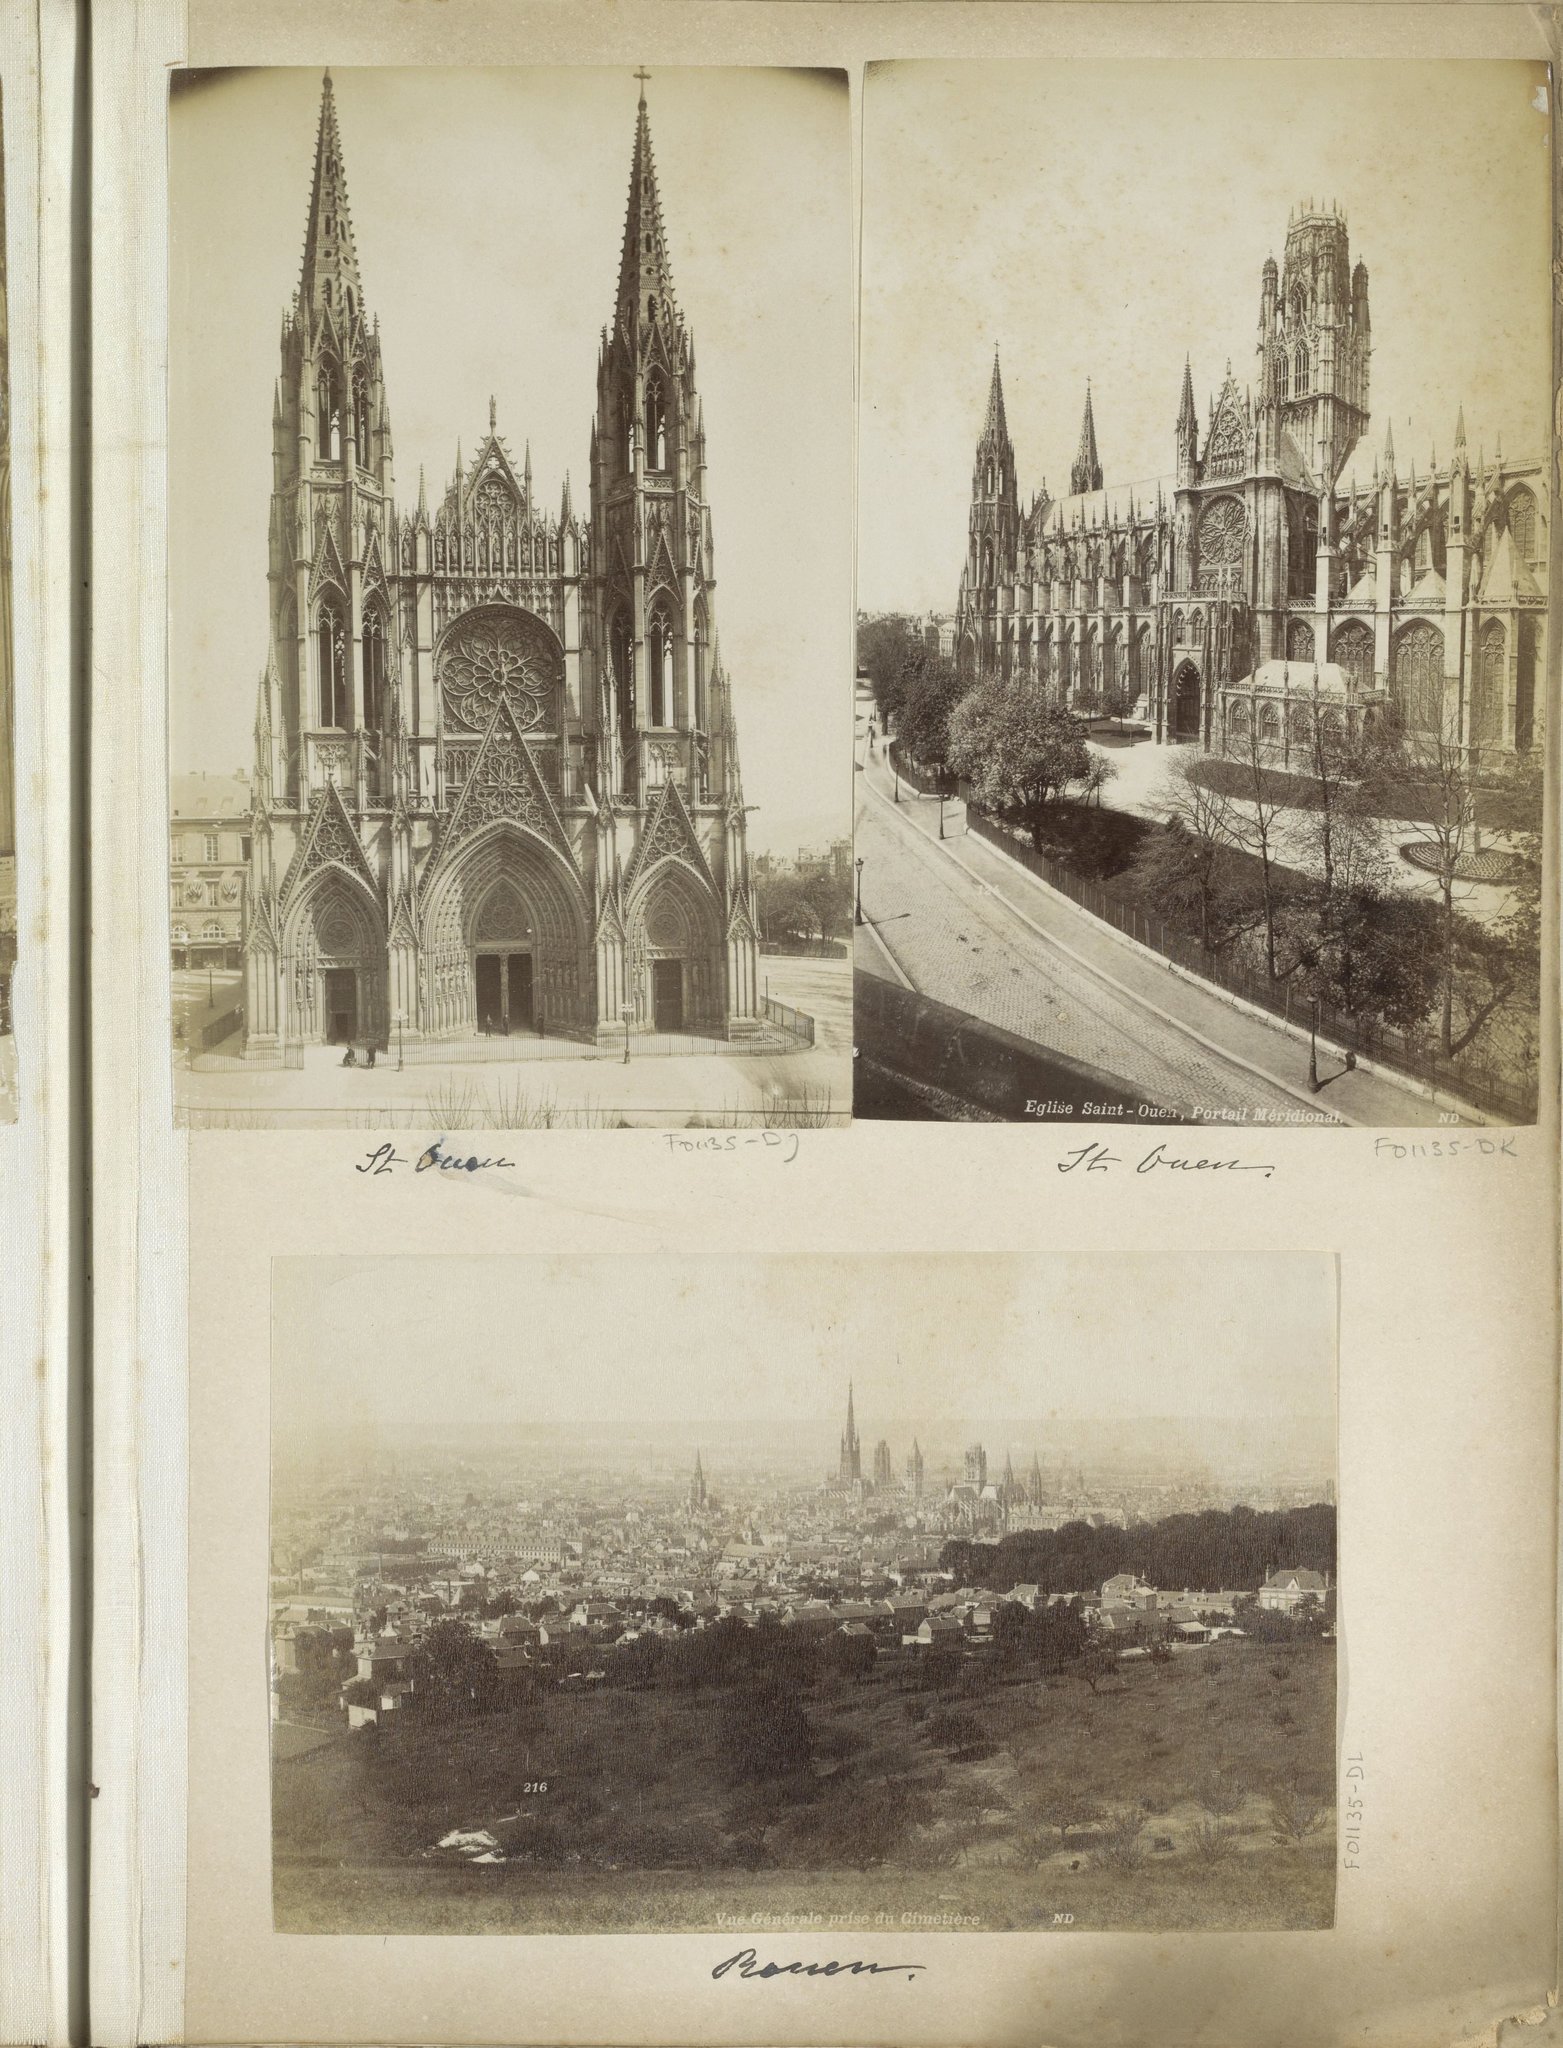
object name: album leaf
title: Exterieur van de abdijkerk van Saint-Ouen in Rouen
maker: Anonymous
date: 1901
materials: paper, photographic support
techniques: albumen print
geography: rouen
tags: parts of church exterior and annexes: portal, church (exterior), parts of church exterior and annexes: tower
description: Onderdeel van Reisalbum met foto's van bezienswaardigheden in Engeland en Frankrijk.